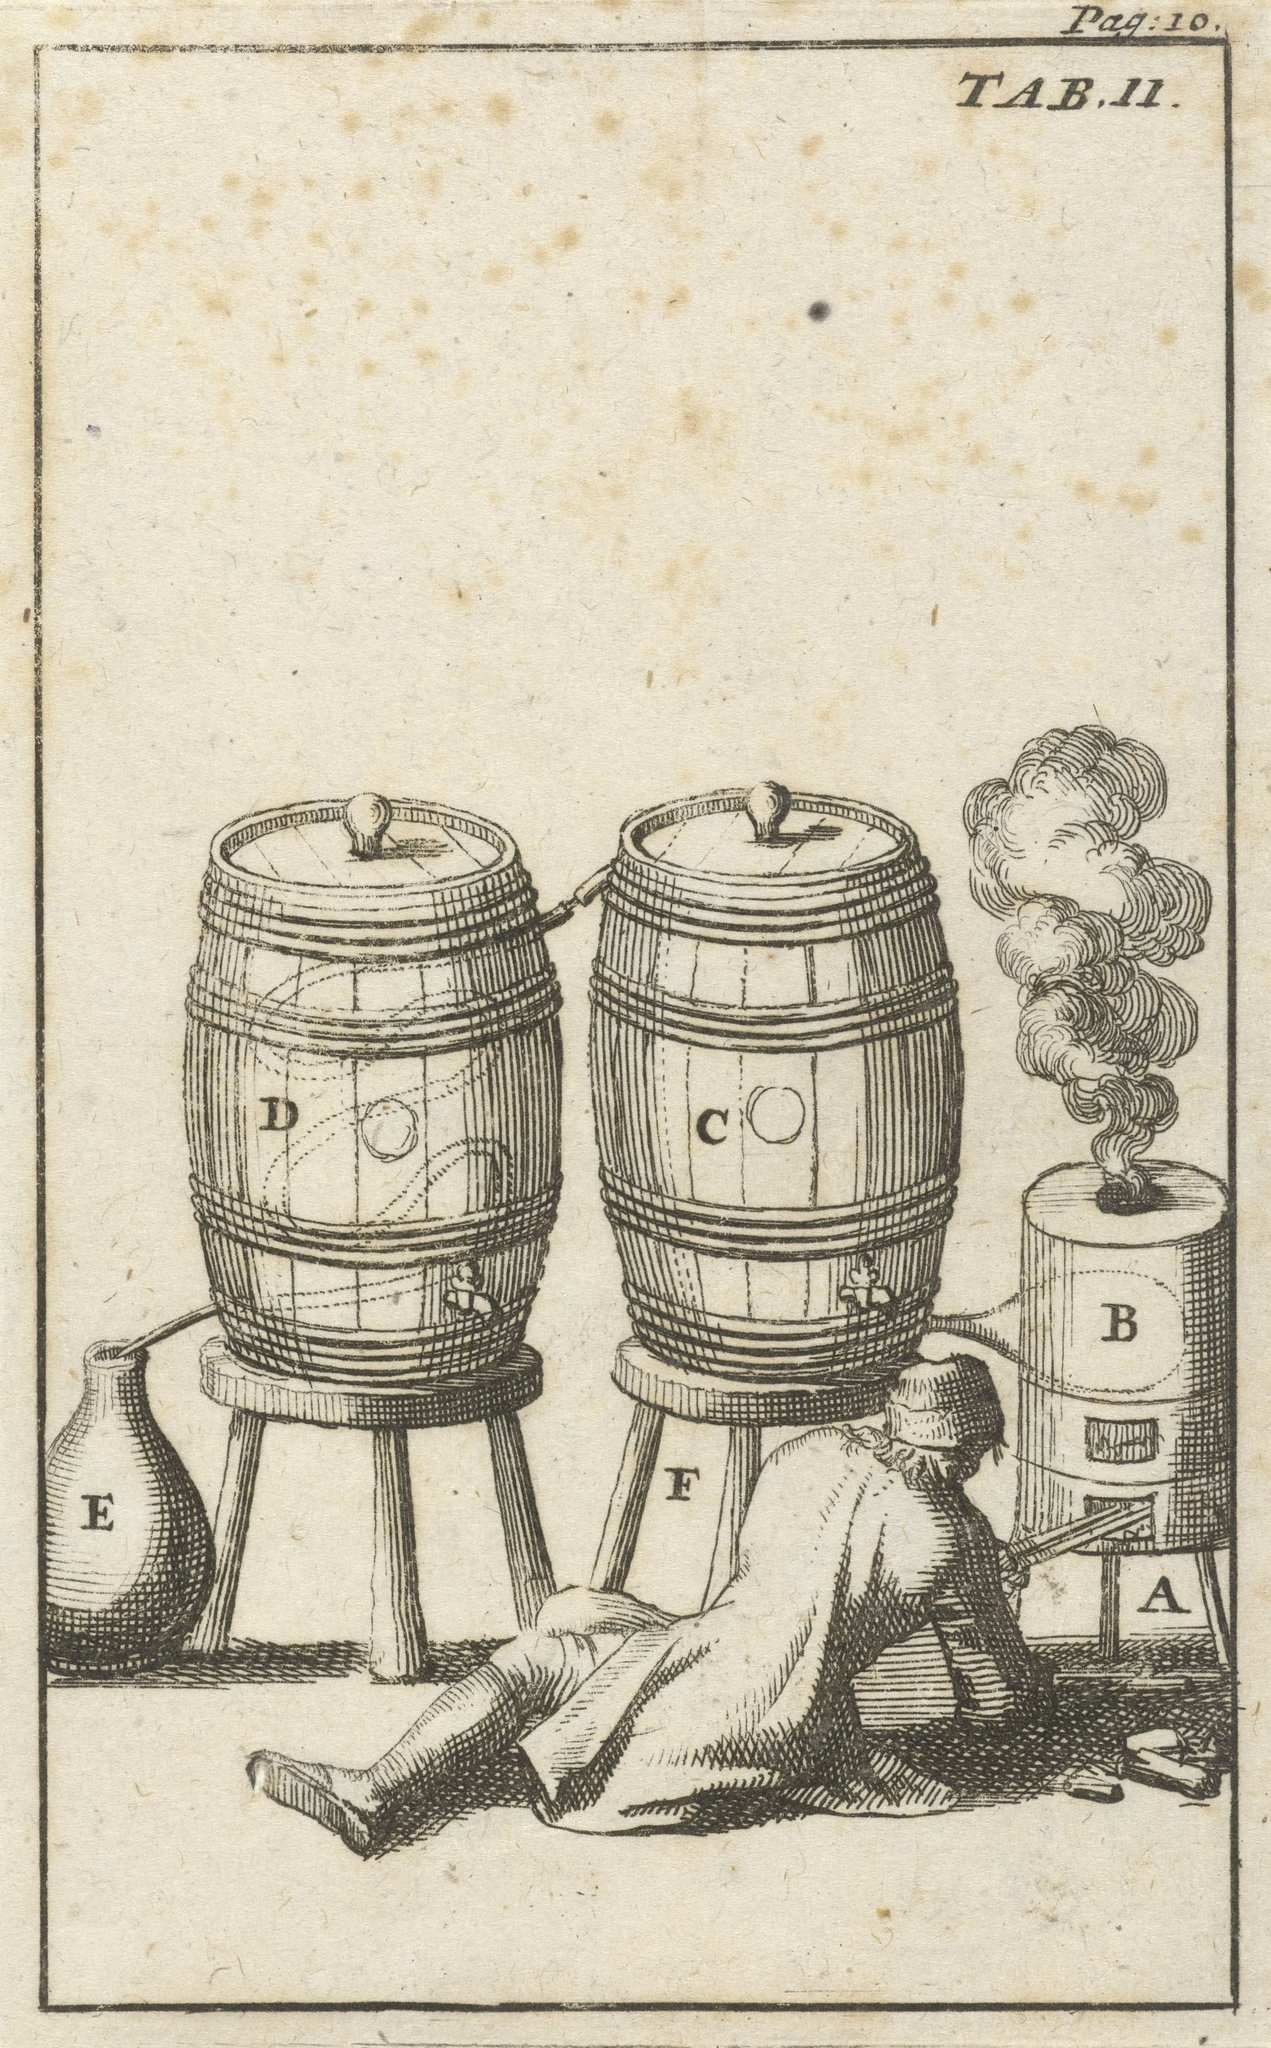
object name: book illustration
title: Distilleertoestel met twee vaten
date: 1693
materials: paper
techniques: etching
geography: amsterdam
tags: laboratory (+ tools, instruments; laboratory equipment ~ scientific research)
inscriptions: collector's mark: Lugt 2228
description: Illustratie uit: Rusting, Salomon van. Nieuwe veld-medicine en chirurgie. Amsterdam: Jan Claesz ten Hoorn, 1693.